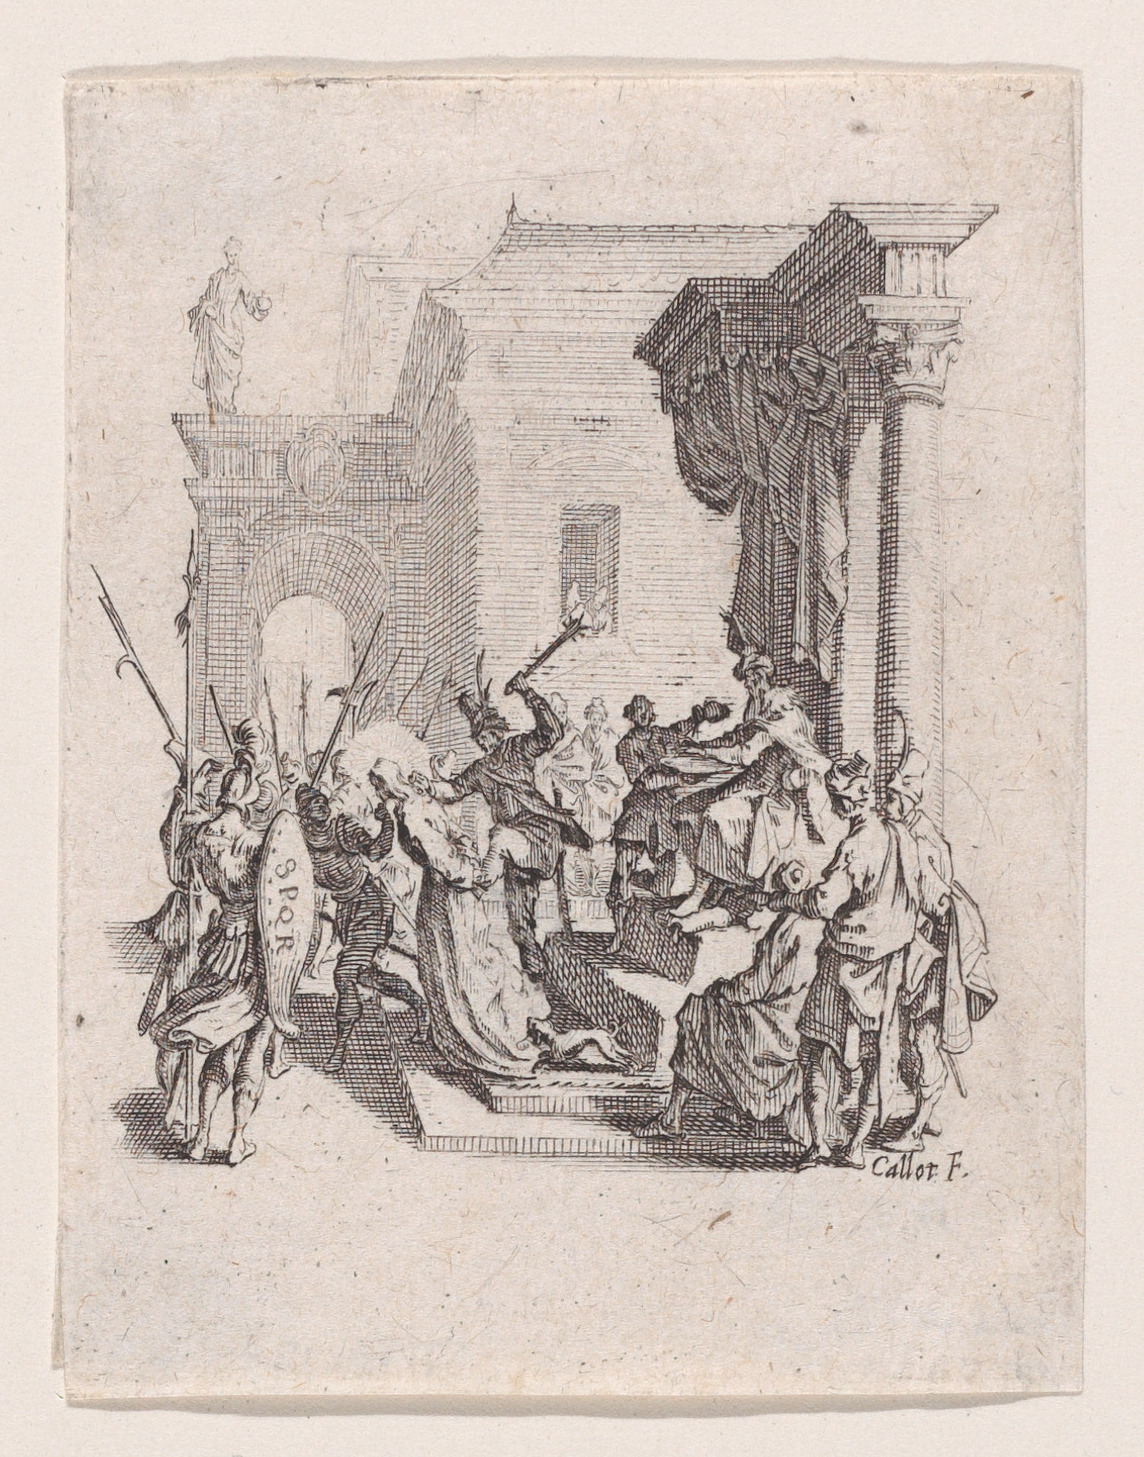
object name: print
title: Jésus et la Femme Adultère (Jesus and the Woman Taken in Adultery), plate 5 from "Le Nouveau Testament" (The New Testament)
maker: jacques callot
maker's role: artist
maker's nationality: french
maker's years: 1592-1635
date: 1635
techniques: etching